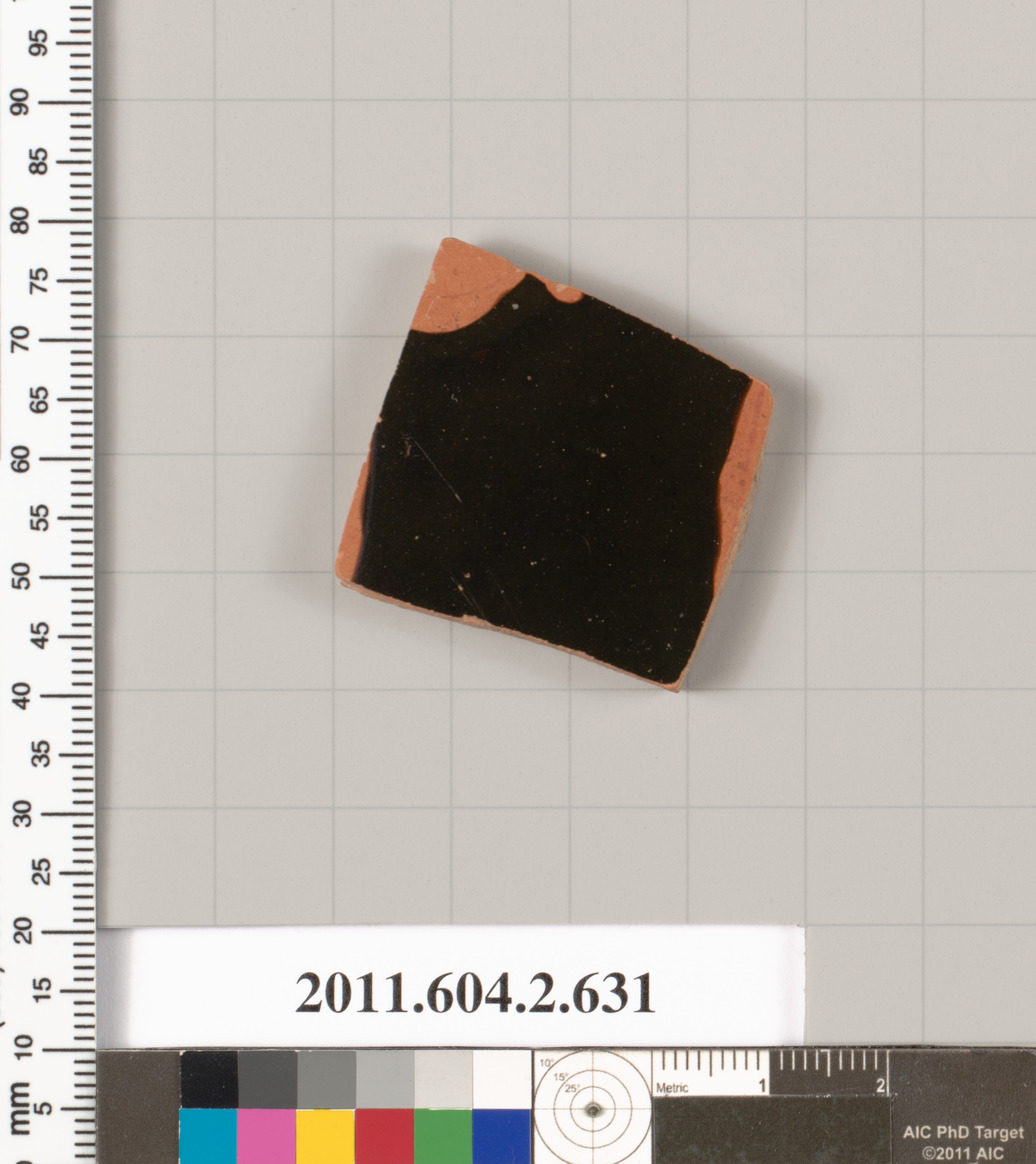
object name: column krater fragment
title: Terracotta fragment of a column-krater (bowl for mixing wine and water)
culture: greek, attic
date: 460-440 BCE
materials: terracotta